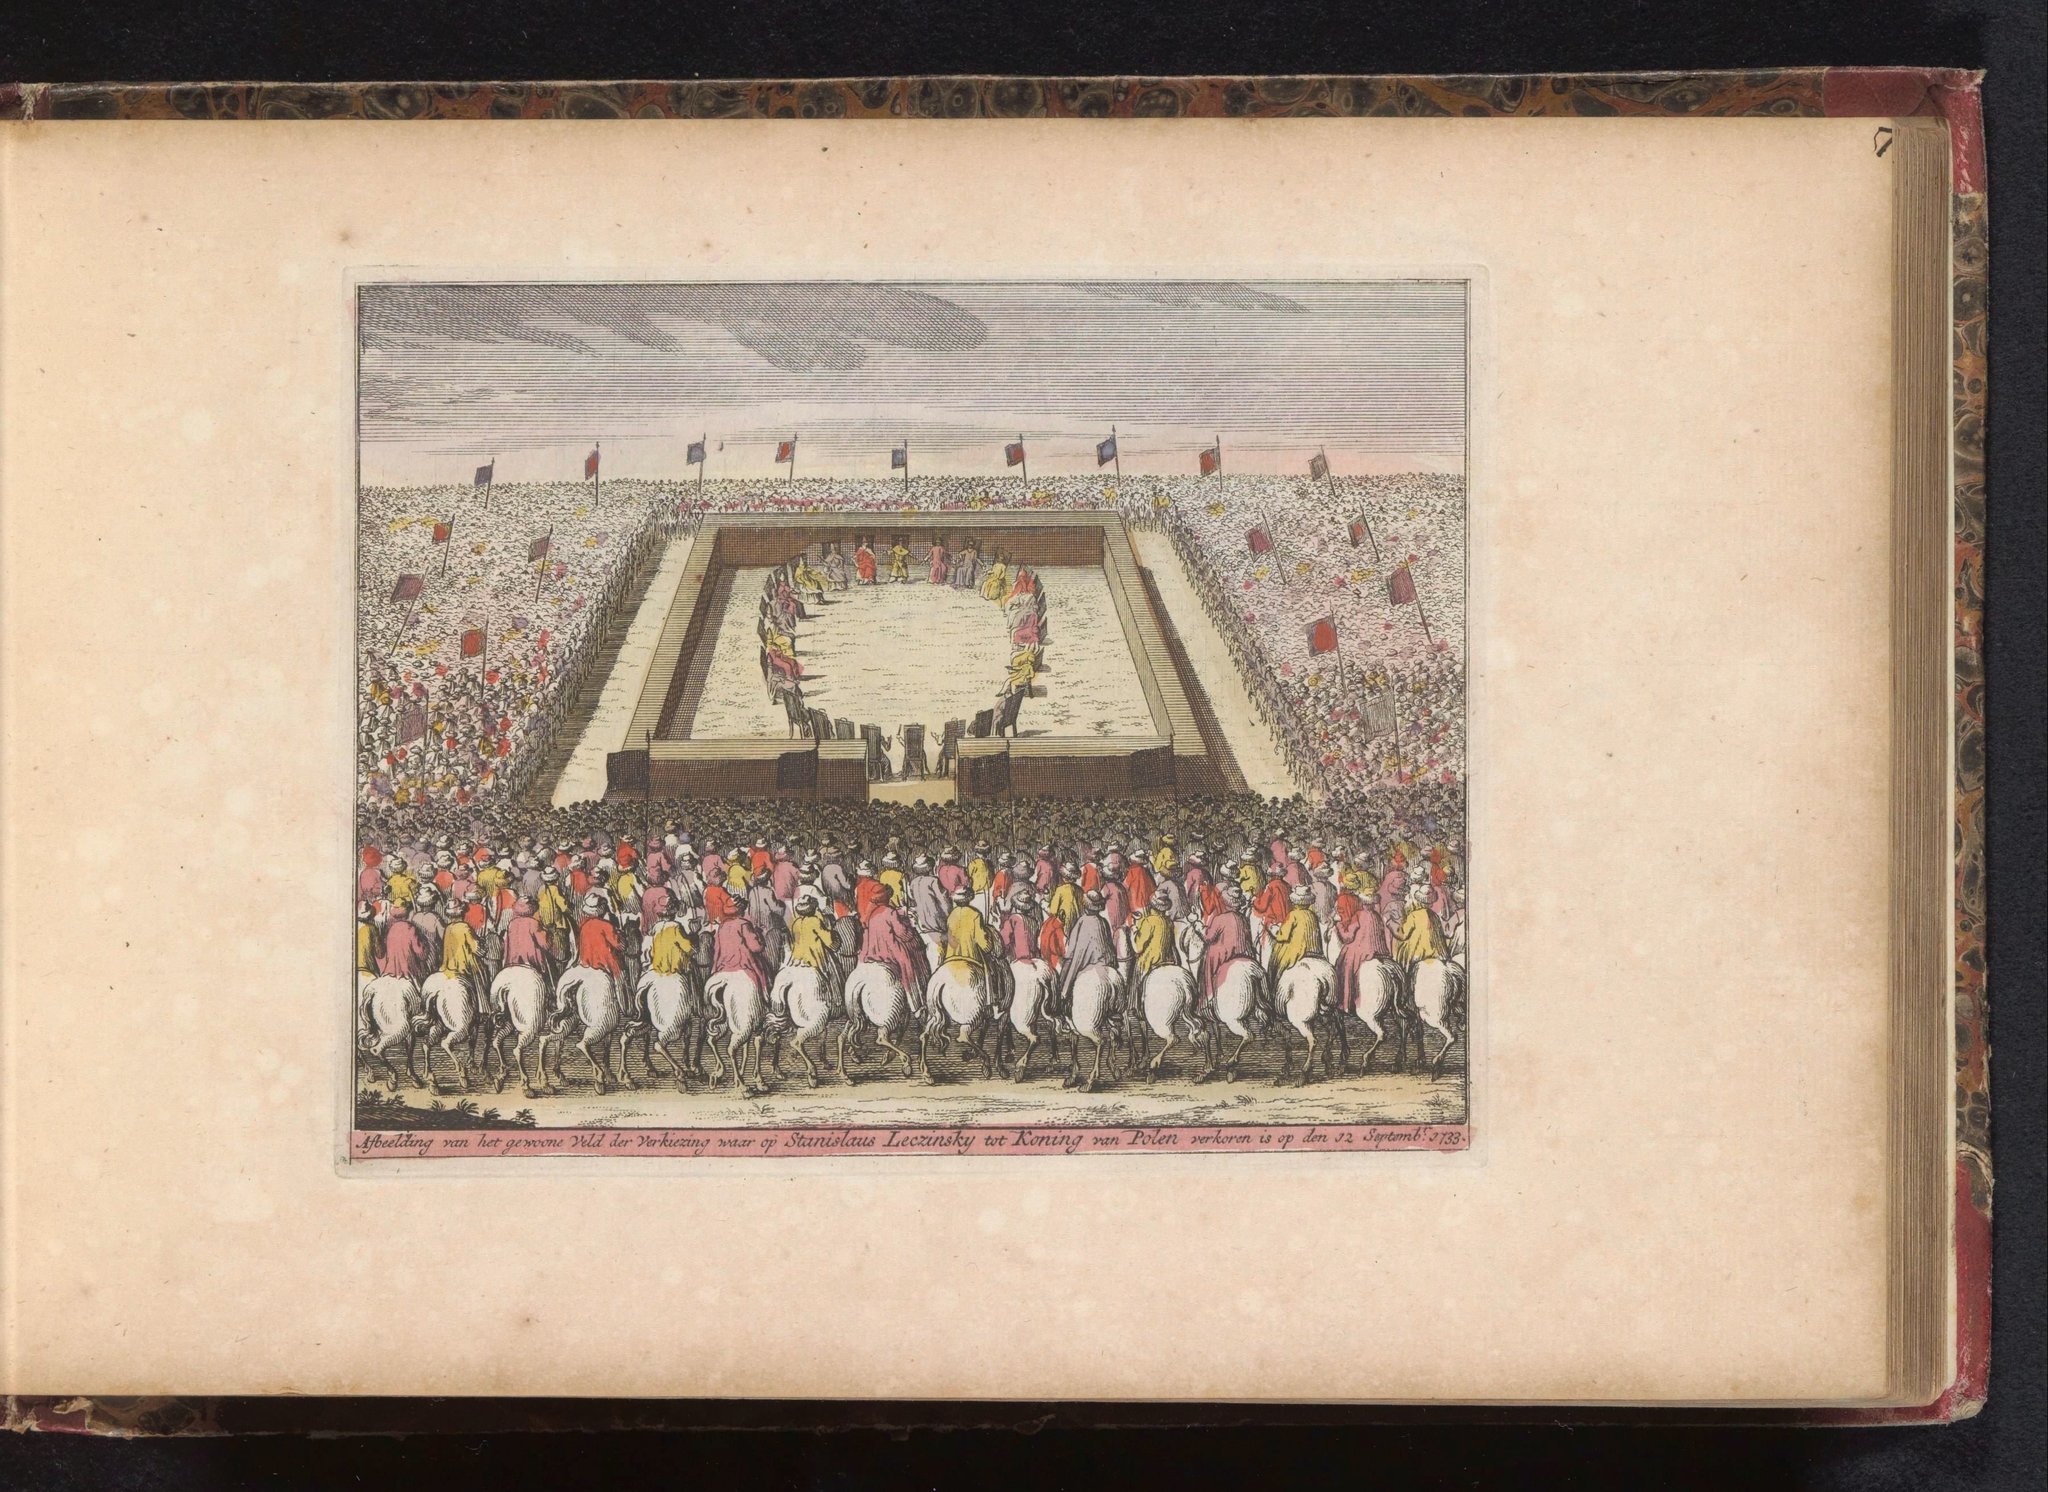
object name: print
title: Afbeelding van het gewone Veld der Verkiezing waar op Stanislaus Leczinsky tot Koning van Polen verkoren is op den 12 Septembr. 1733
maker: Anonymous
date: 1735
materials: paper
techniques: engraving, etching, hand coloring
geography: amsterdam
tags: election, choice of a ruler, poland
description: Verkiezing van Stanislaus Leszczyński tot koning van Polen op 12 september 1733. Vergadering gehouden in de open lucht omringd door een grote menigte, op de voorgrond ruiters. Onderdeel van een atlas met 223 kaarten van landen en steden en oorlogstaferelen in Europa in de periode ca. 1690-1735.